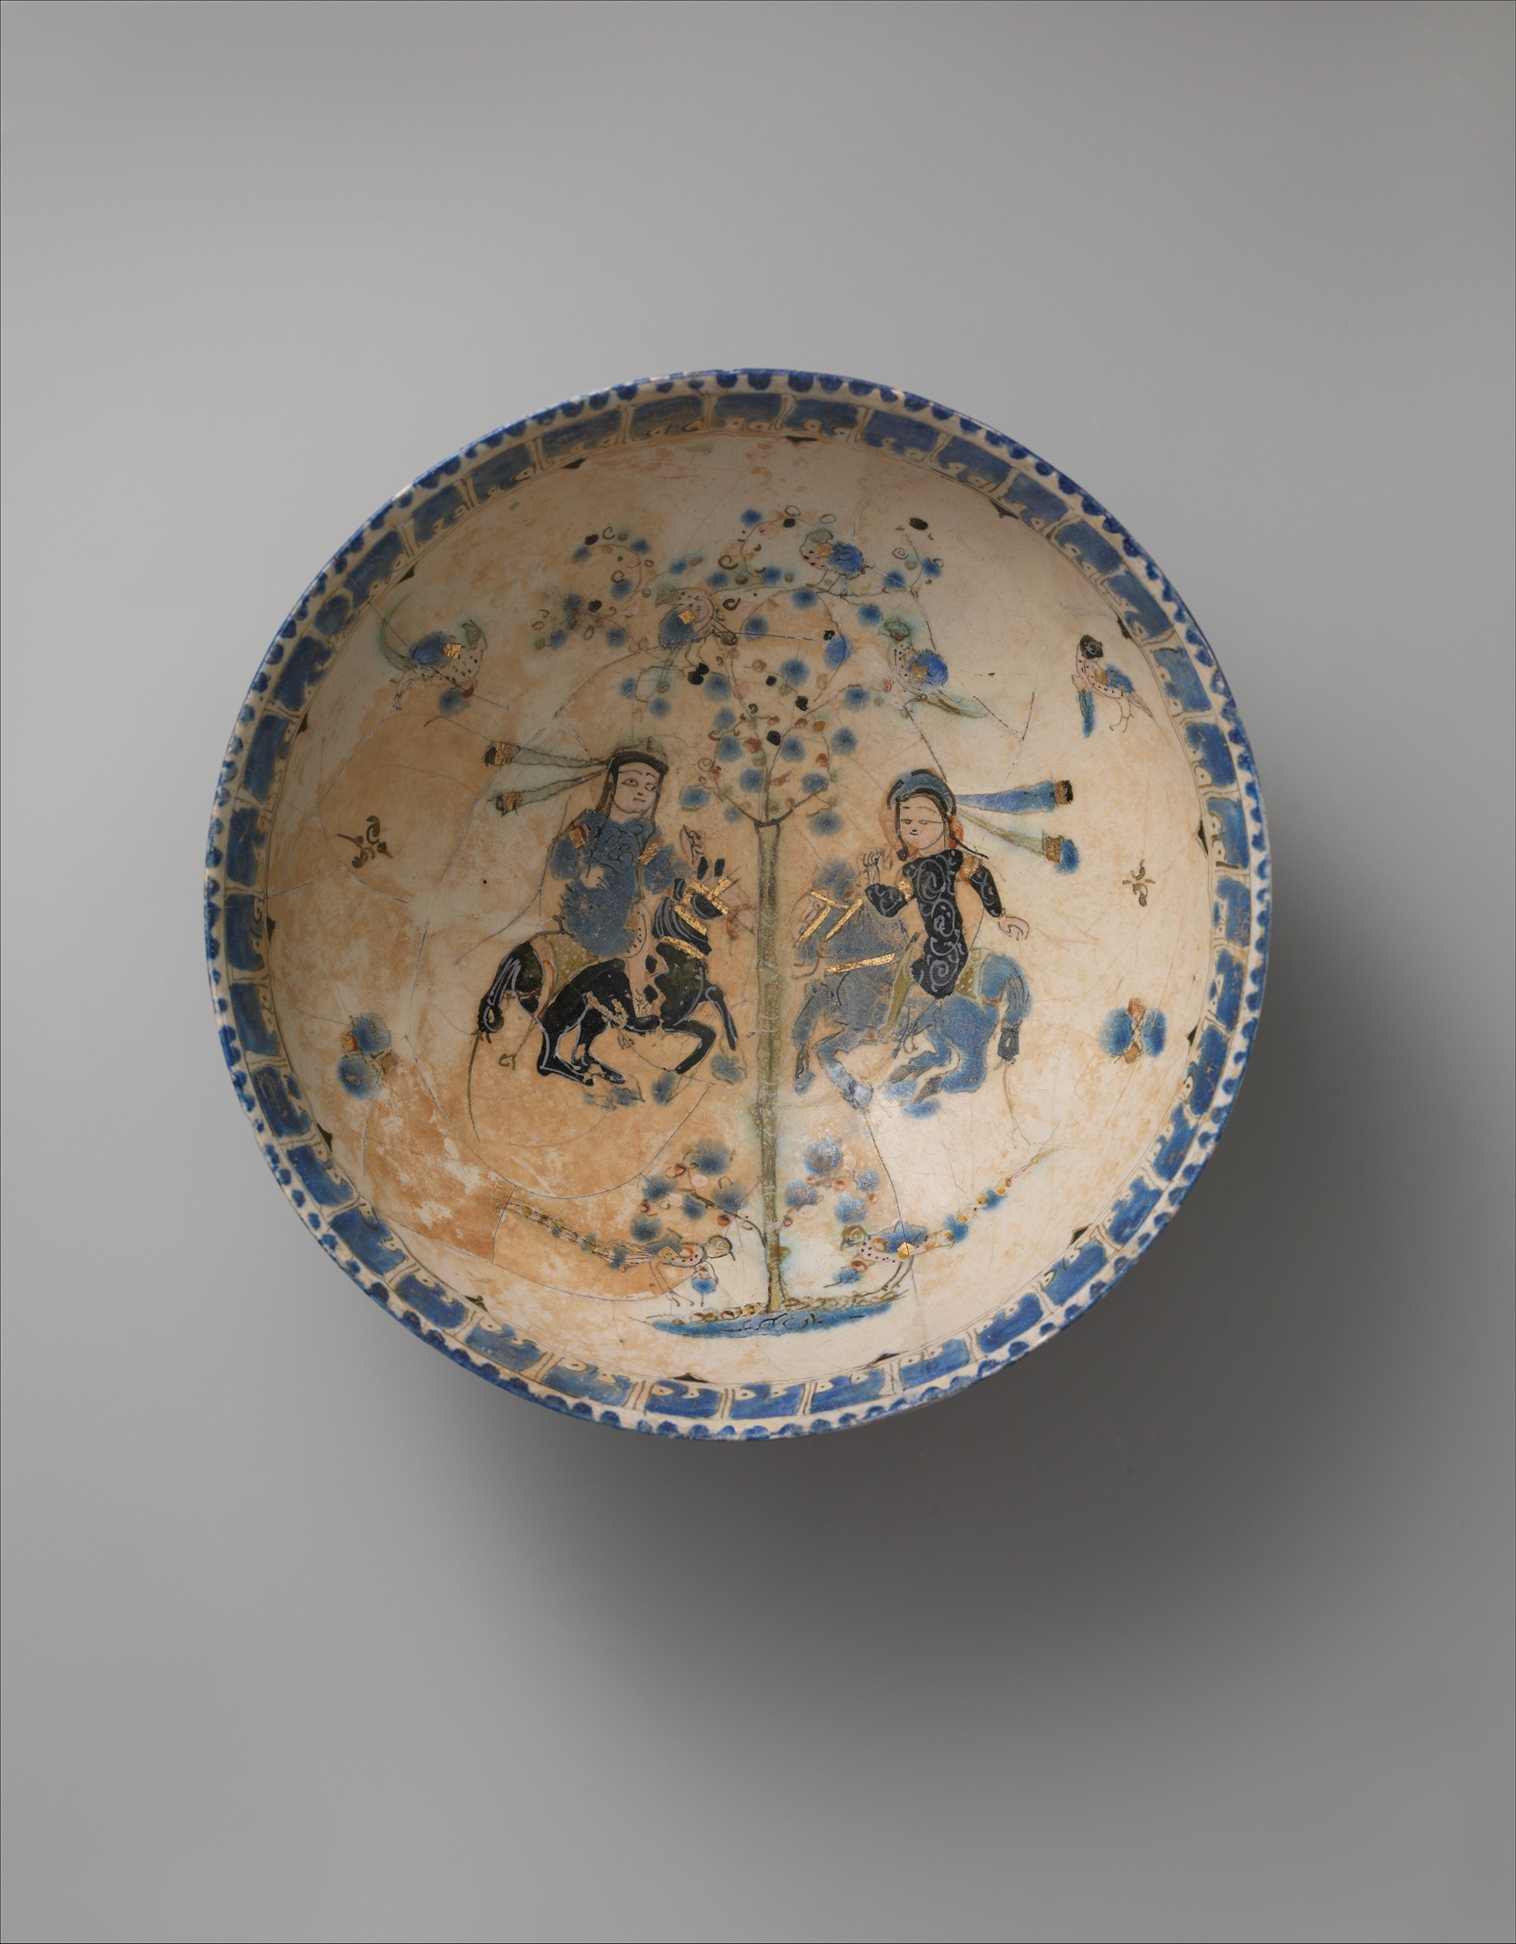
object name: bowl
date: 1101-1300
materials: stonepaste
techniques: overglaze, painting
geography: iran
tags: human figures,birds,horses